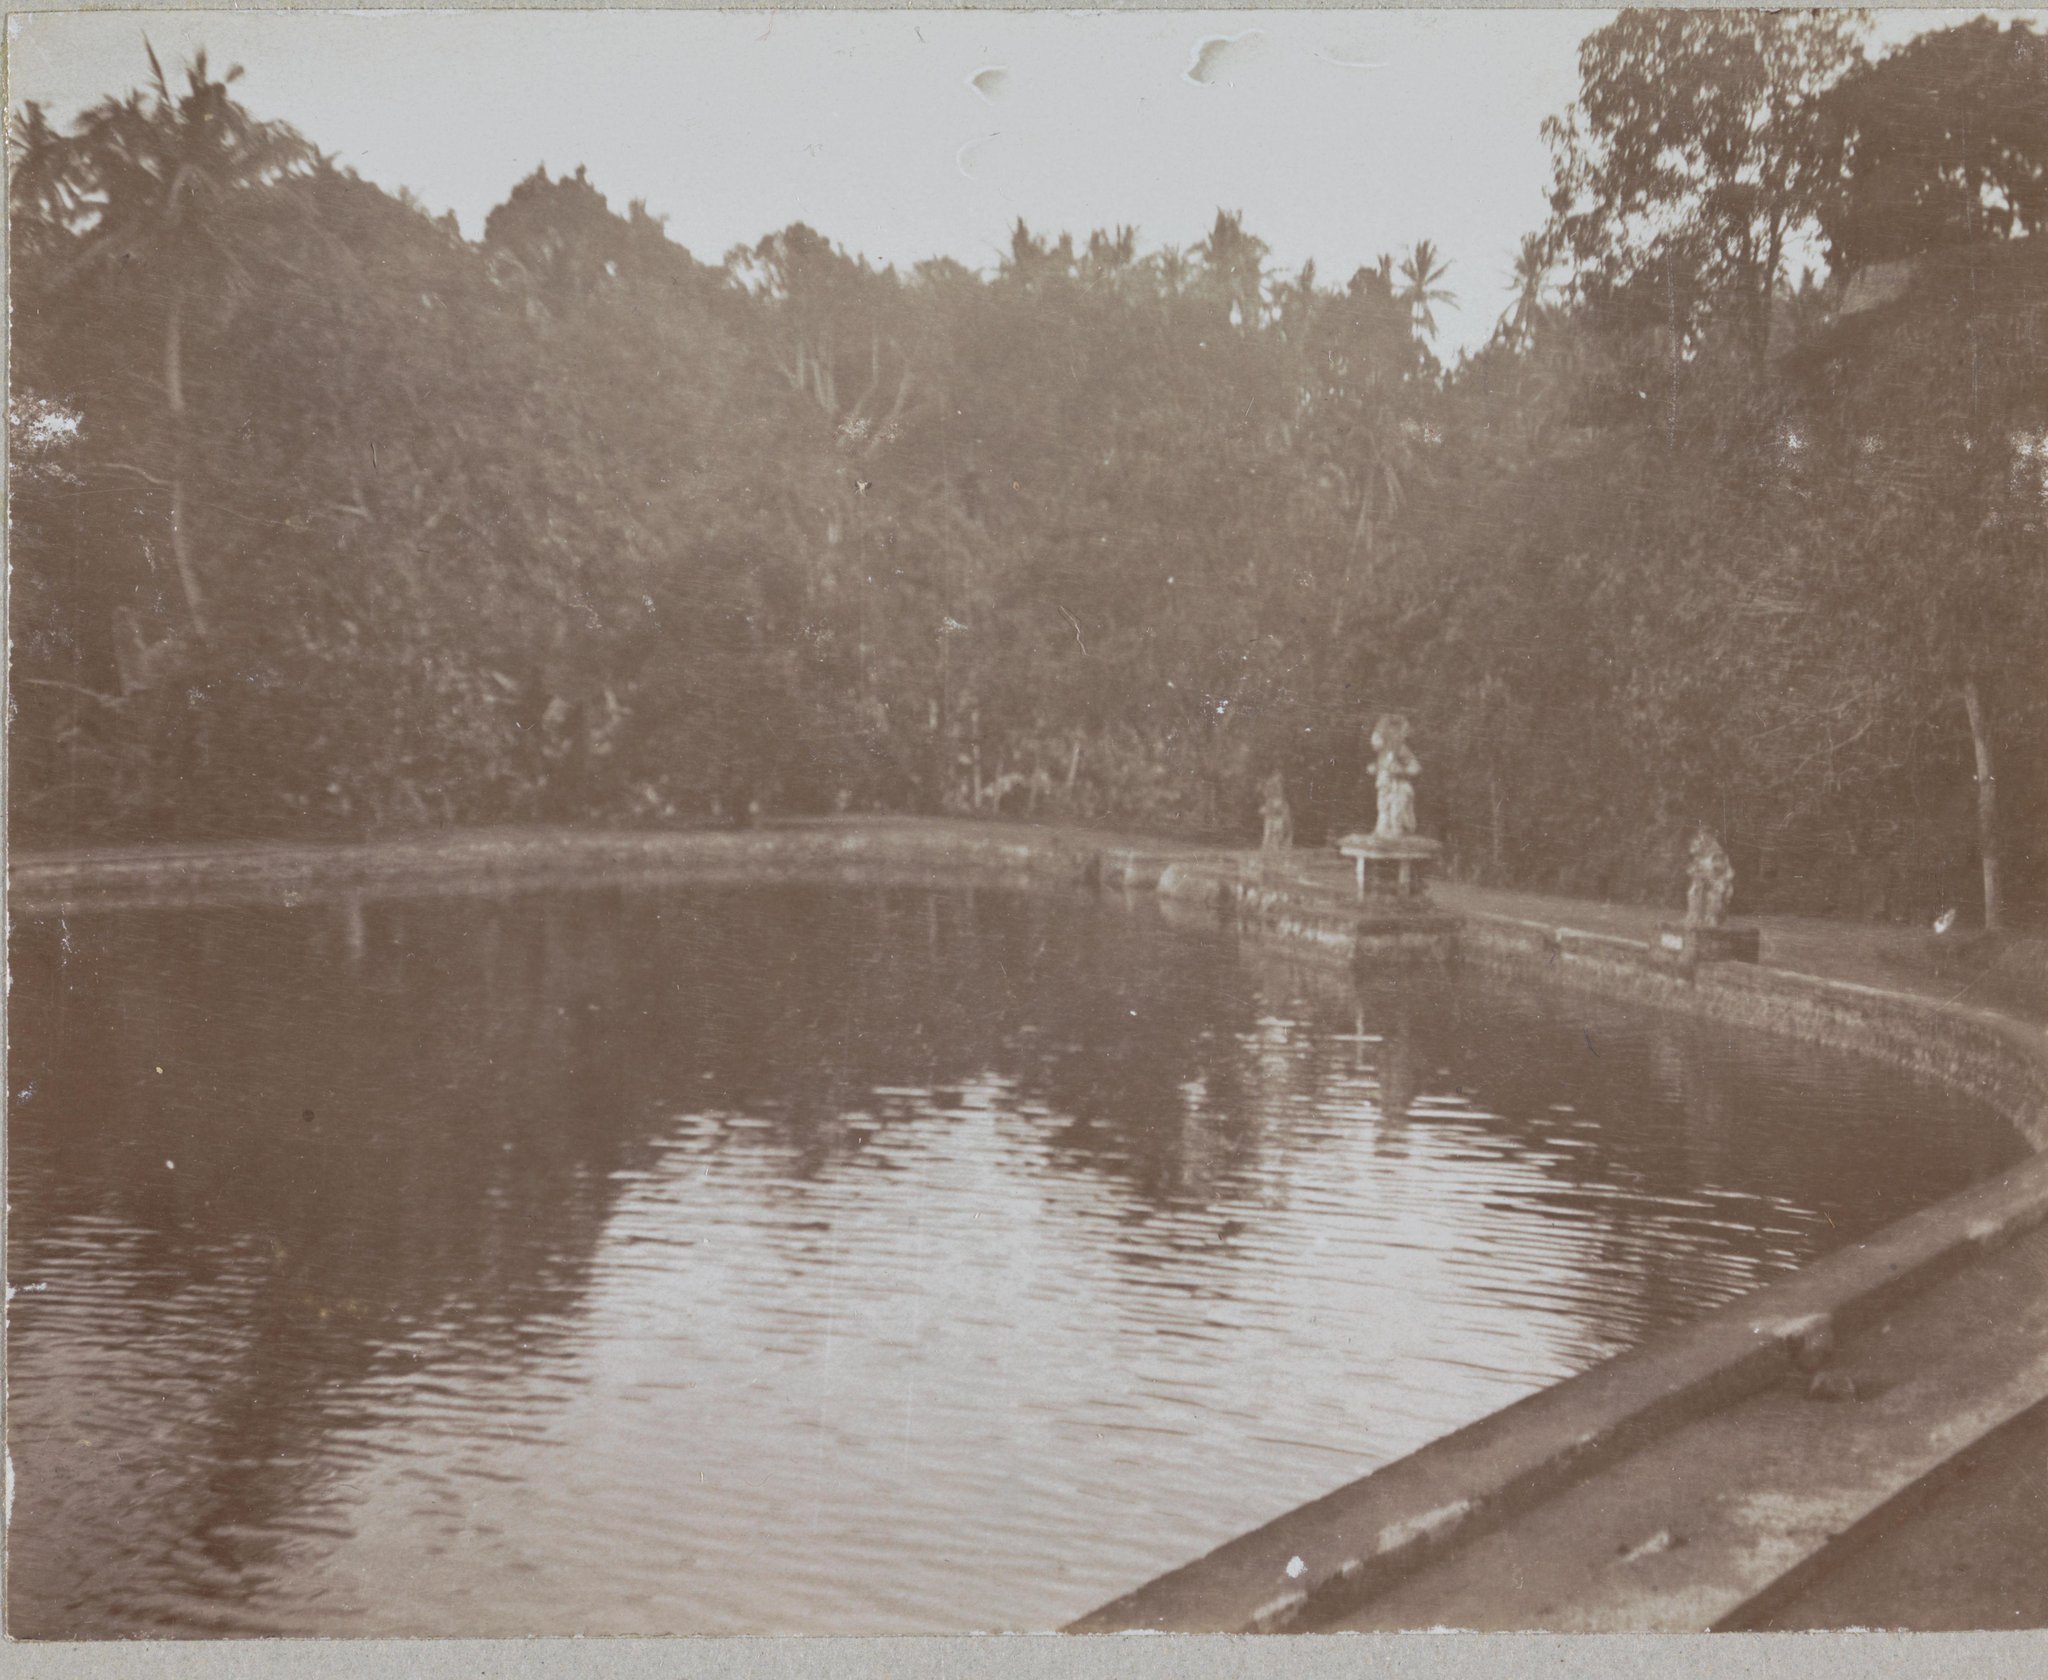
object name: photograph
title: Vijver met drie beelden aan de rand, Marmada, Lombok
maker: Anonymous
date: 1895-1915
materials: cardboard, paper, photographic support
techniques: collodion silver print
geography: lombok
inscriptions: annotation: ‘4) Marmada } Lombok’